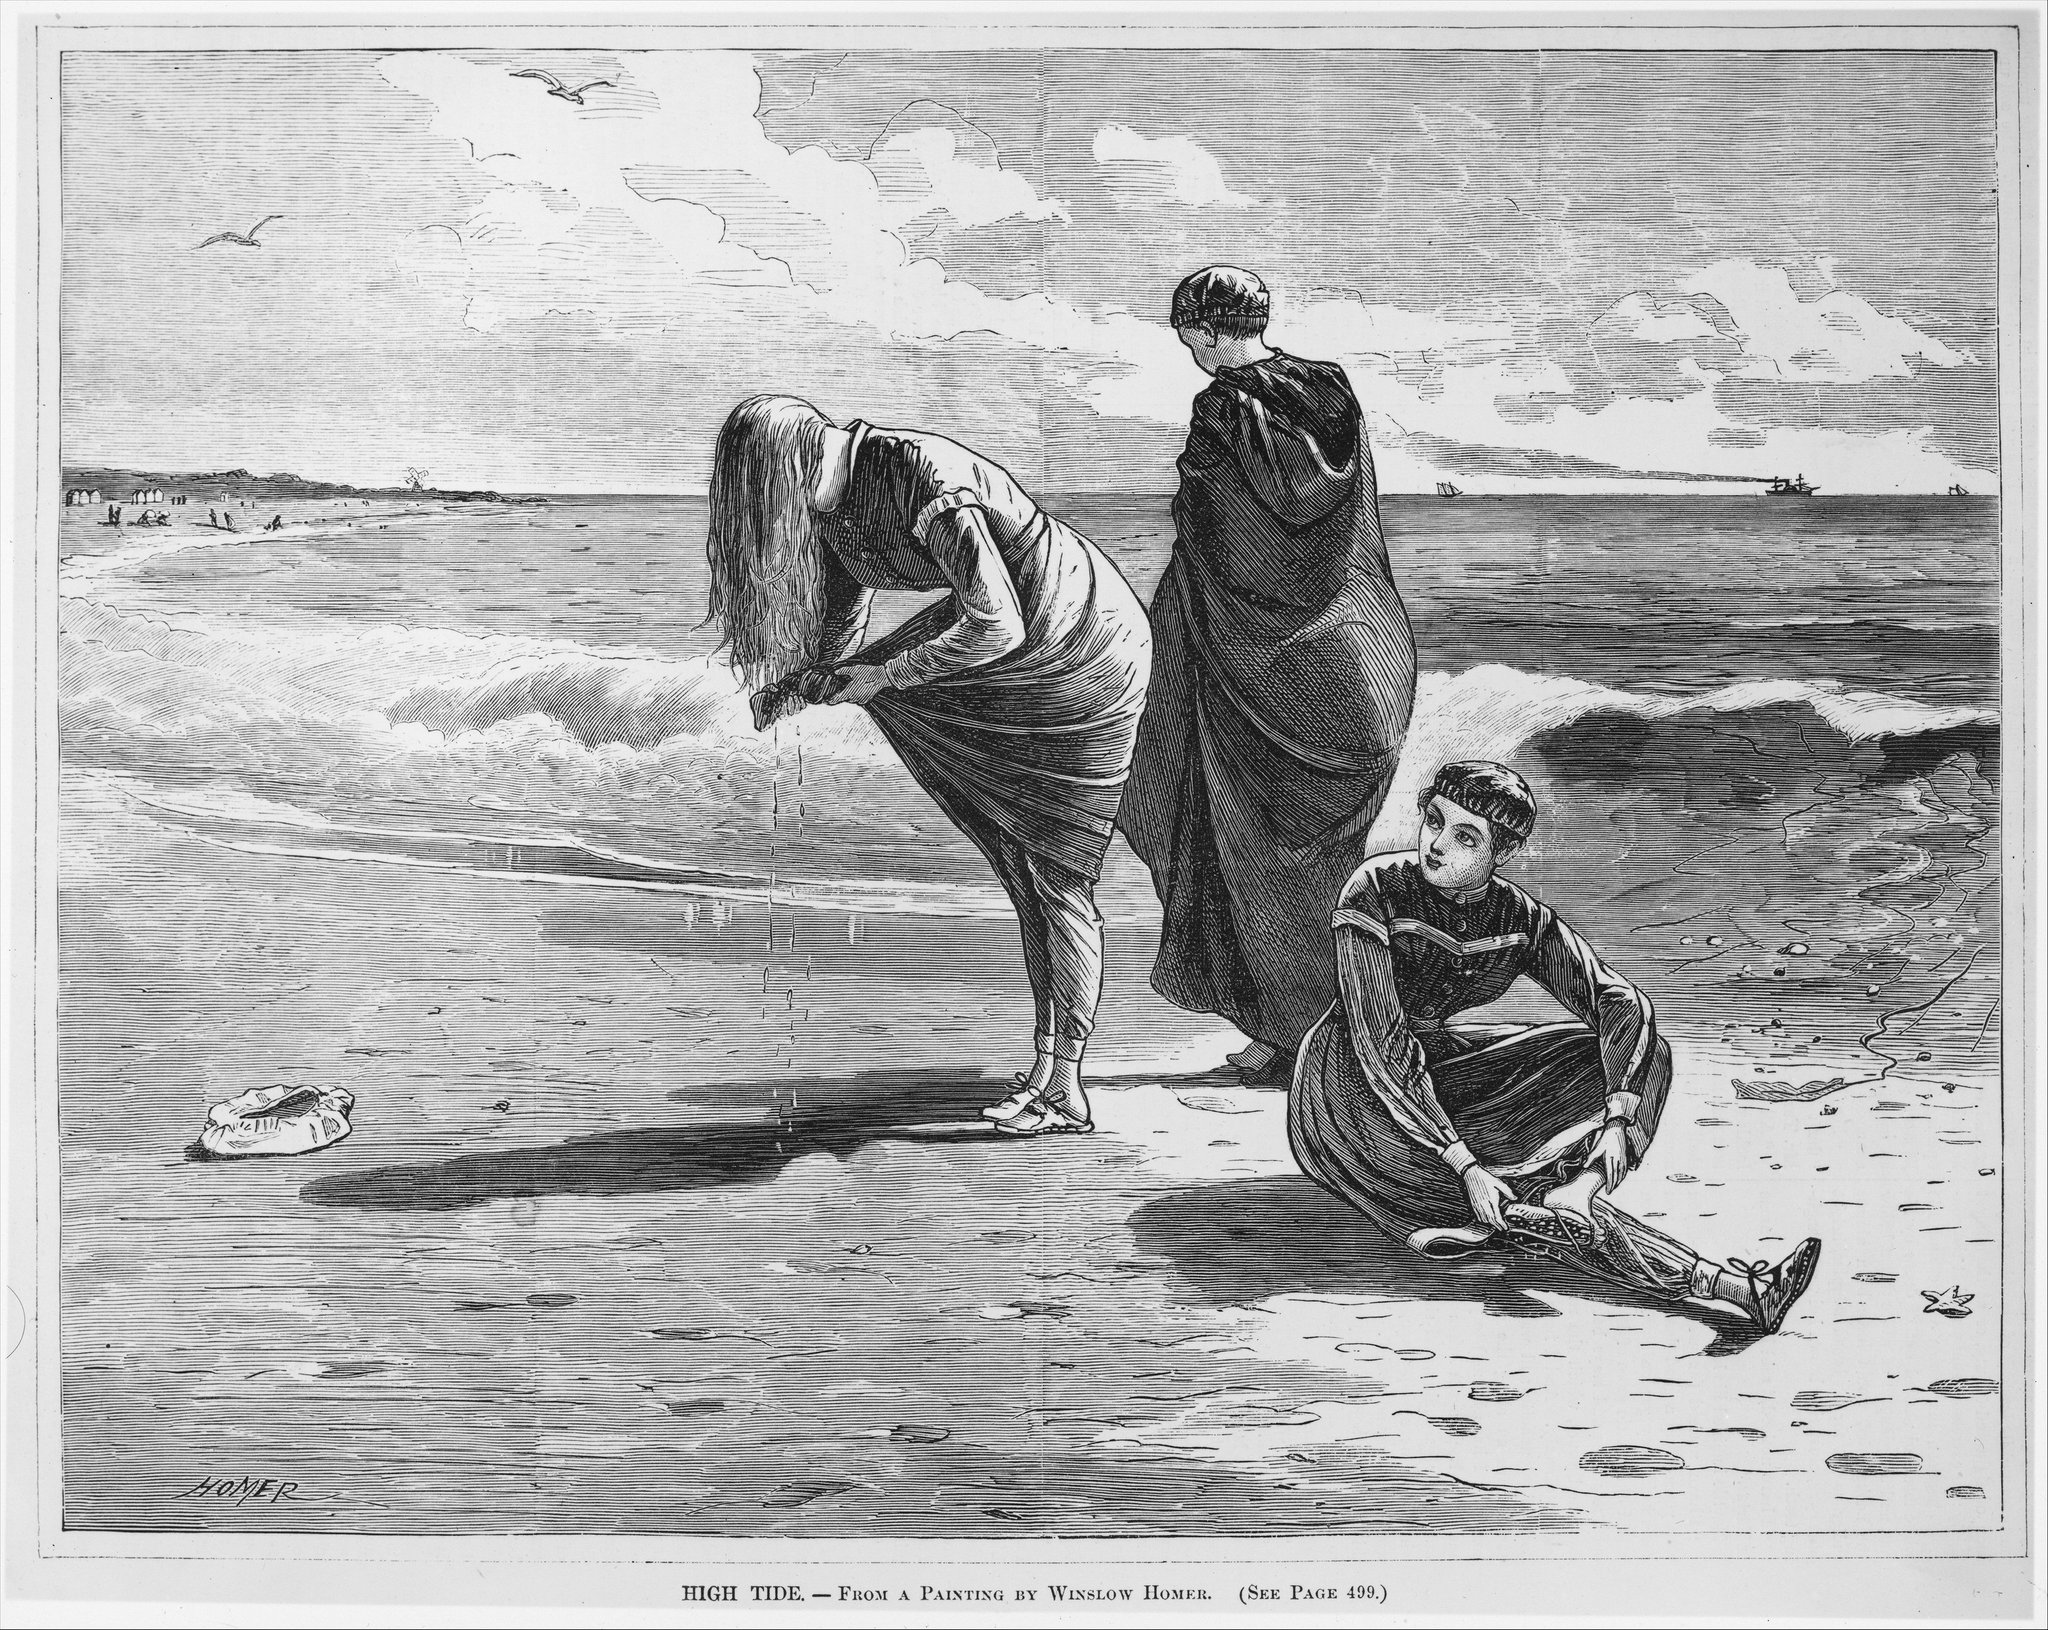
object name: print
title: High Tide (from "Every Saturday," Vol. I, New Series)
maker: winslow homer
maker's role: artist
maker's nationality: american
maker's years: 1836-1910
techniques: engraving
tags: women,beaches